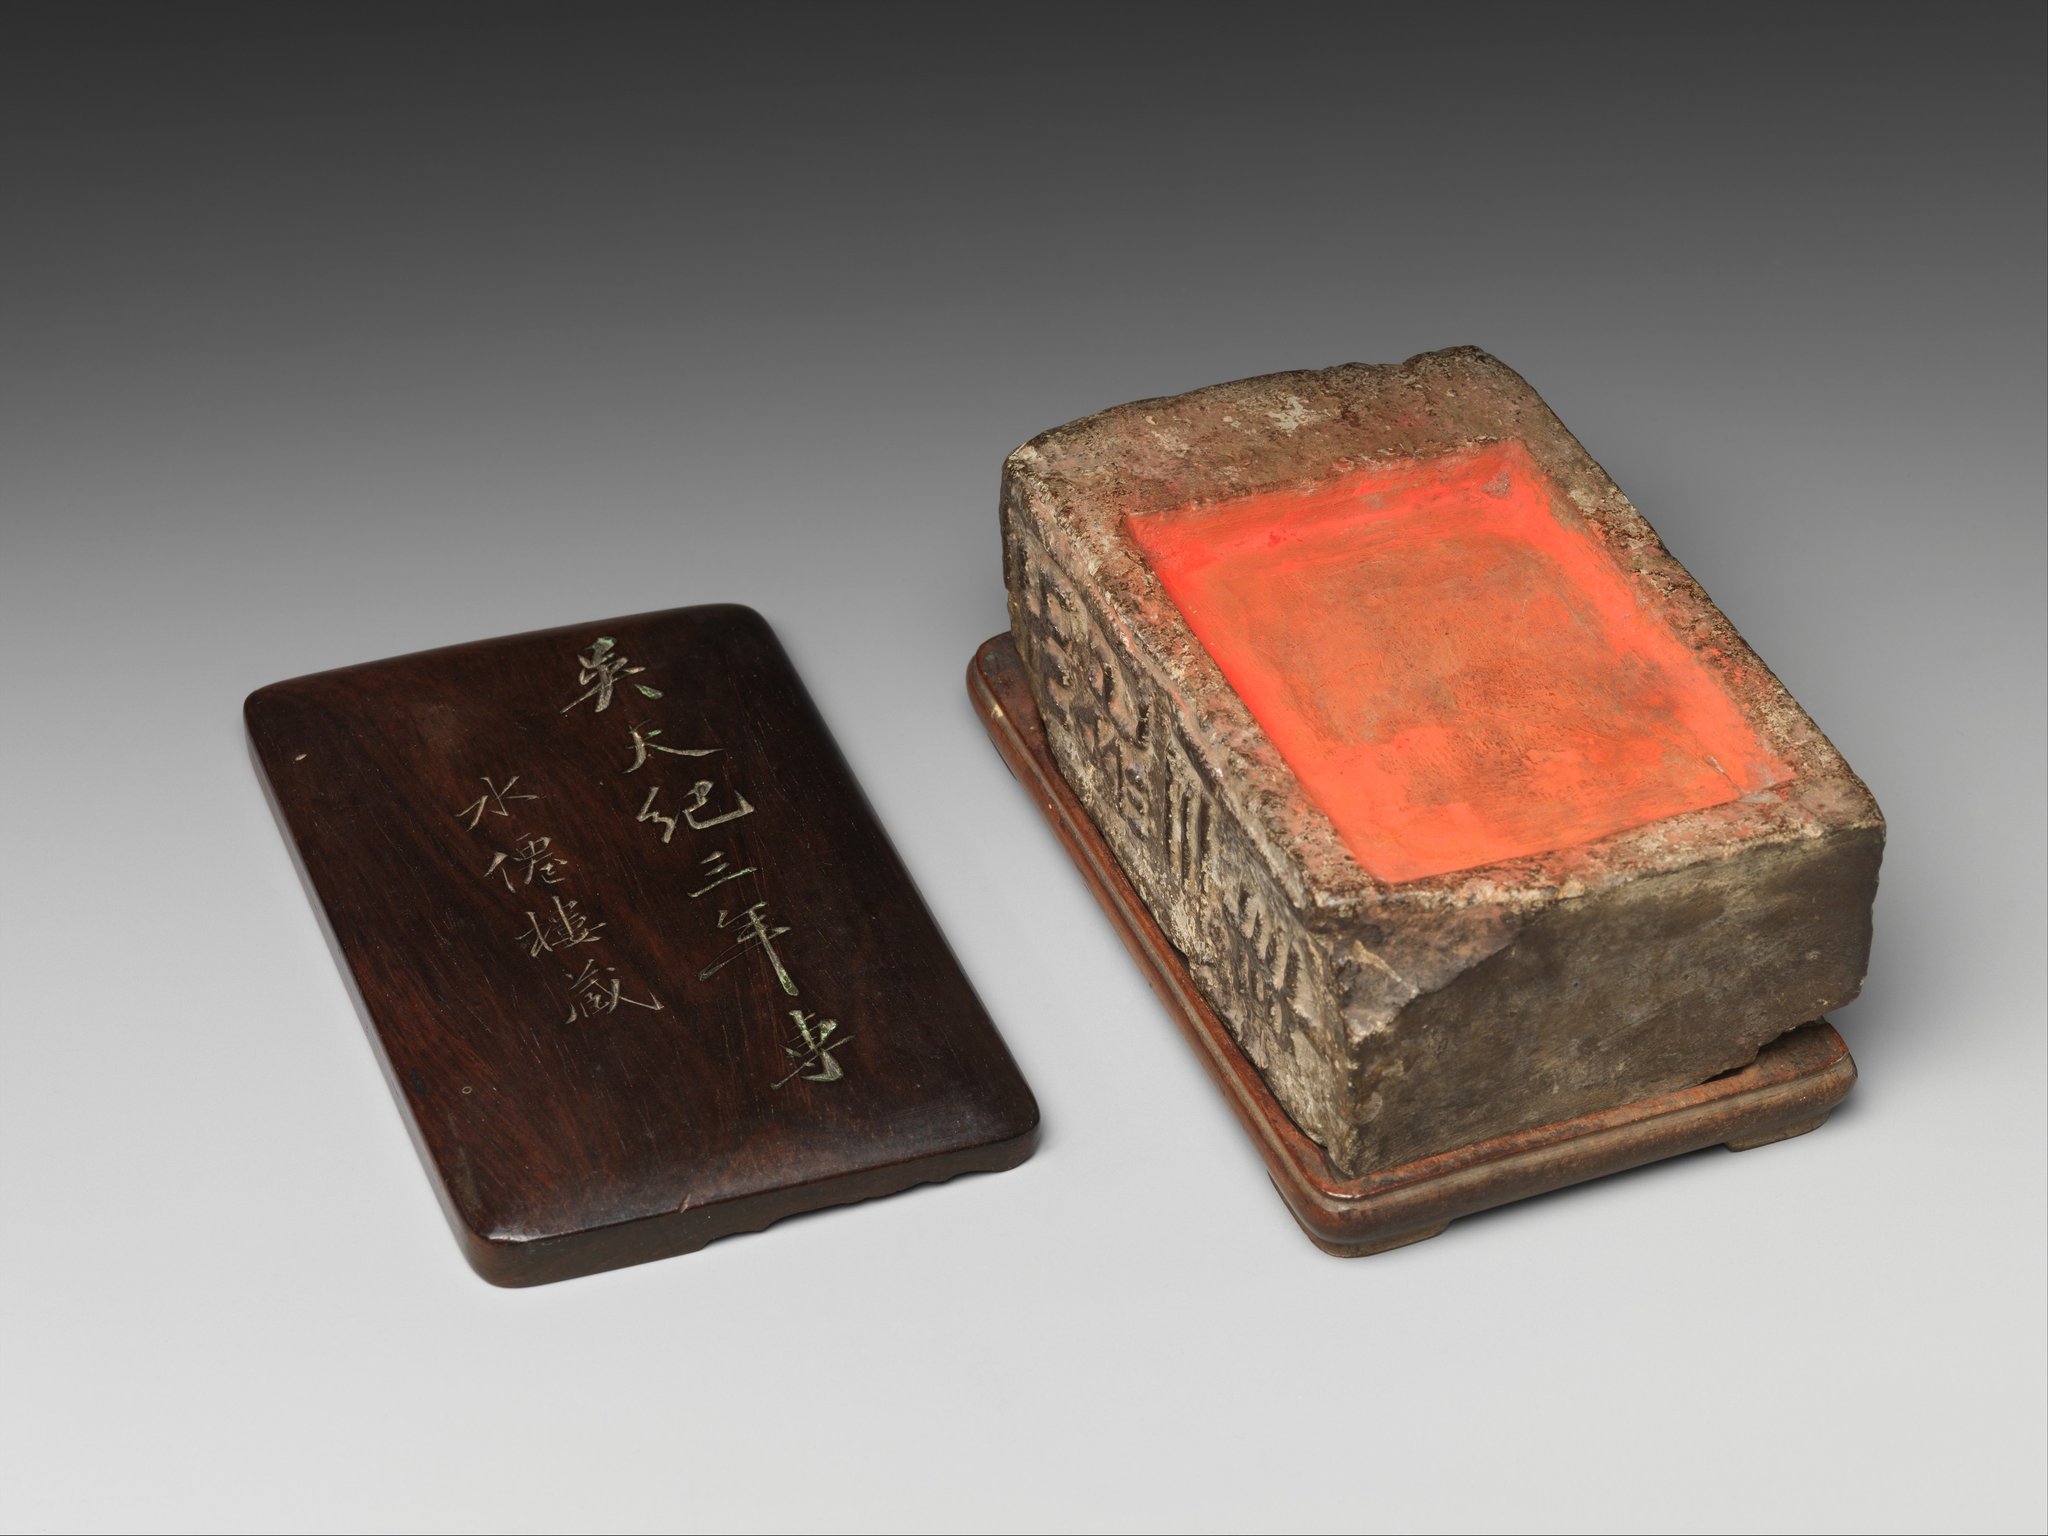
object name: ink pallet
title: Ink palette carved from an ancient brick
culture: chinese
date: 1801-1900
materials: earthenware, wood